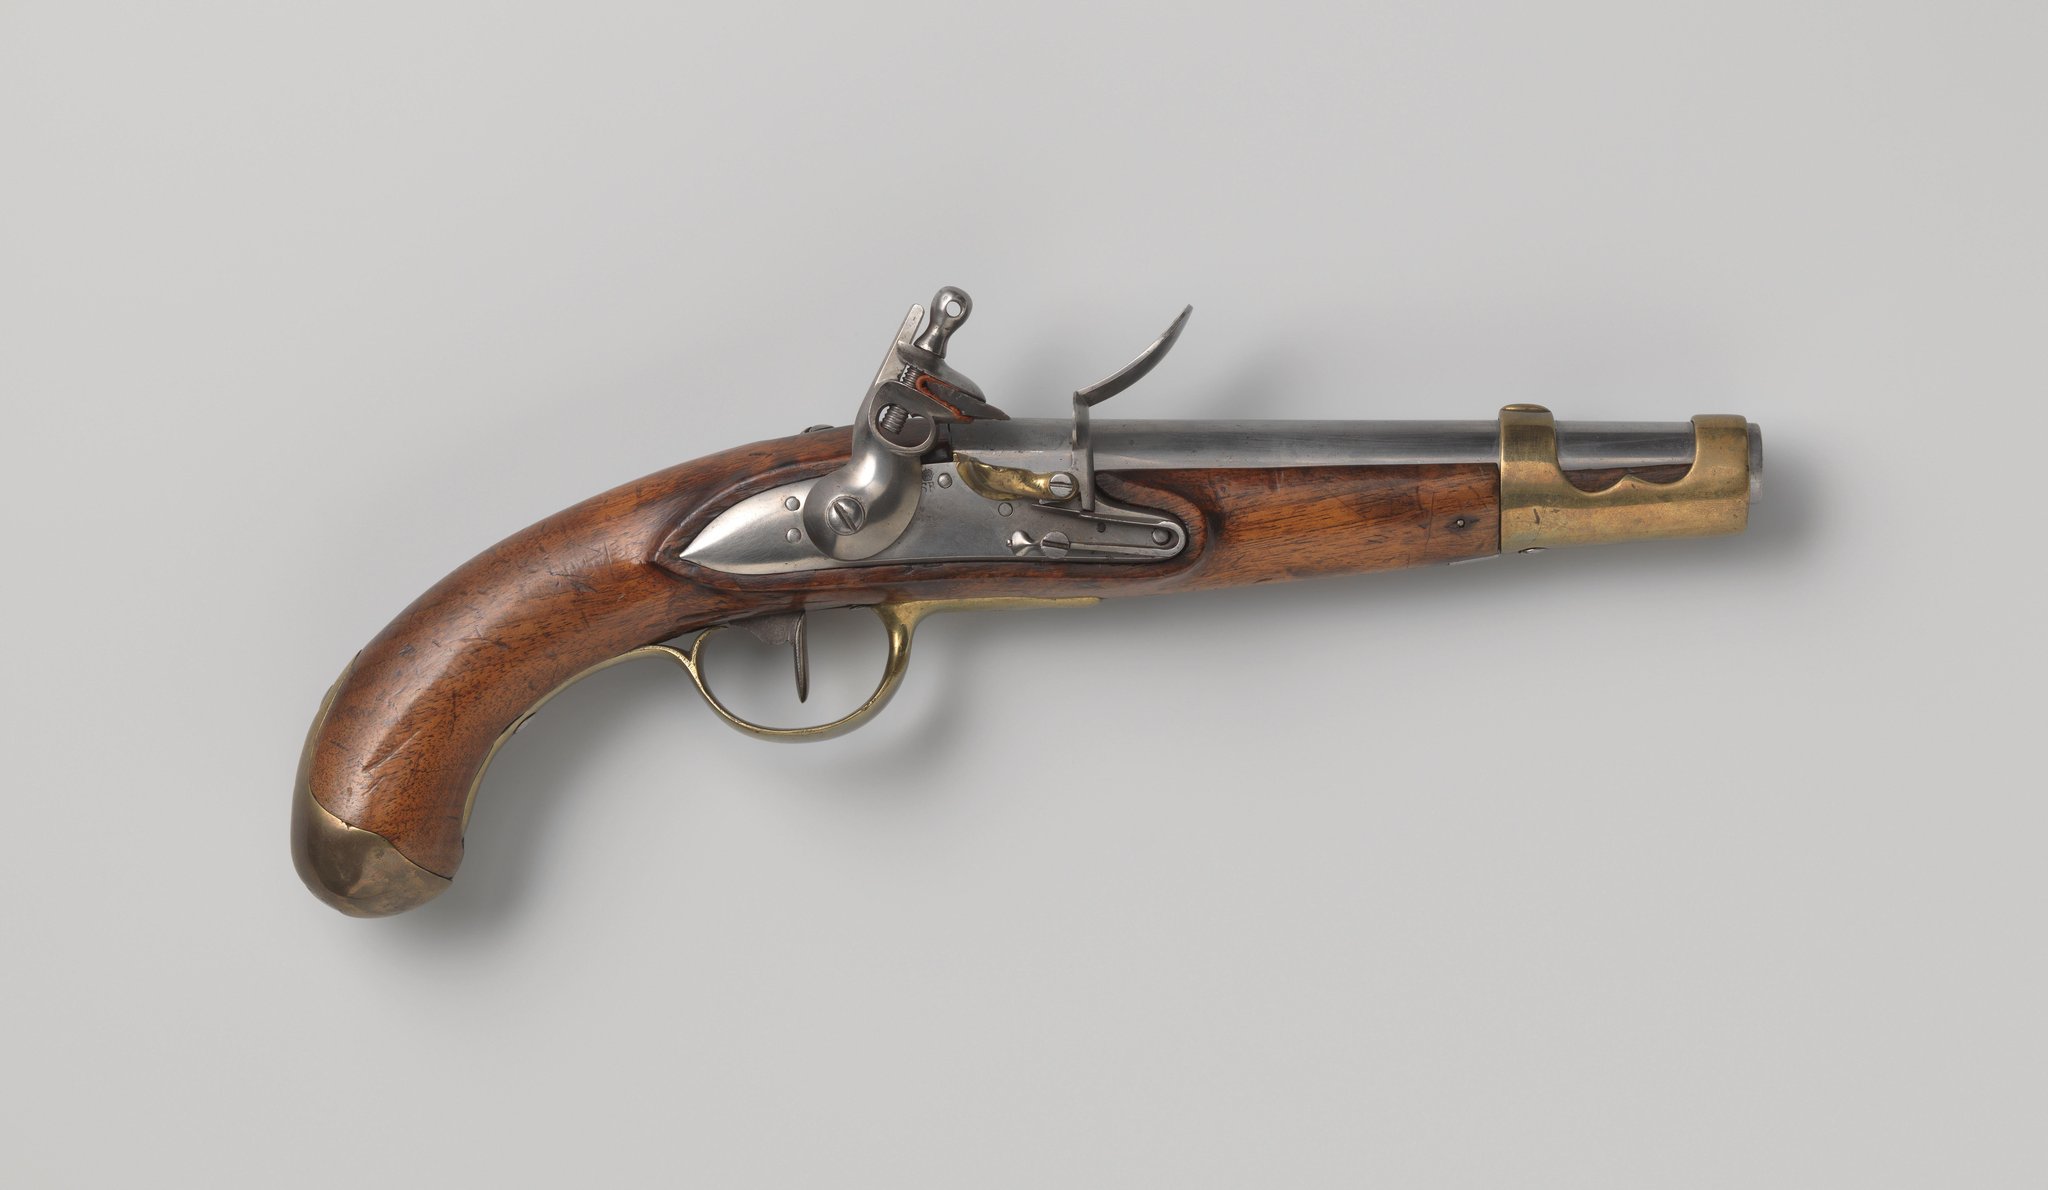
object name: flintlock pistol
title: Vuursteenpistool voor de Lichte Cavalerie, Nederlandse Armee, Model 1815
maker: Anonymous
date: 1815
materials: brass, stone, iron, wood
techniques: printing, engraving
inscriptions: mark: ‘HP; 41’, stamp: ‘W; 1815’, mark: ‘1815; LR’, mark: ‘A // 54 // 18’, inscription: ‘A // 54; M.1815’